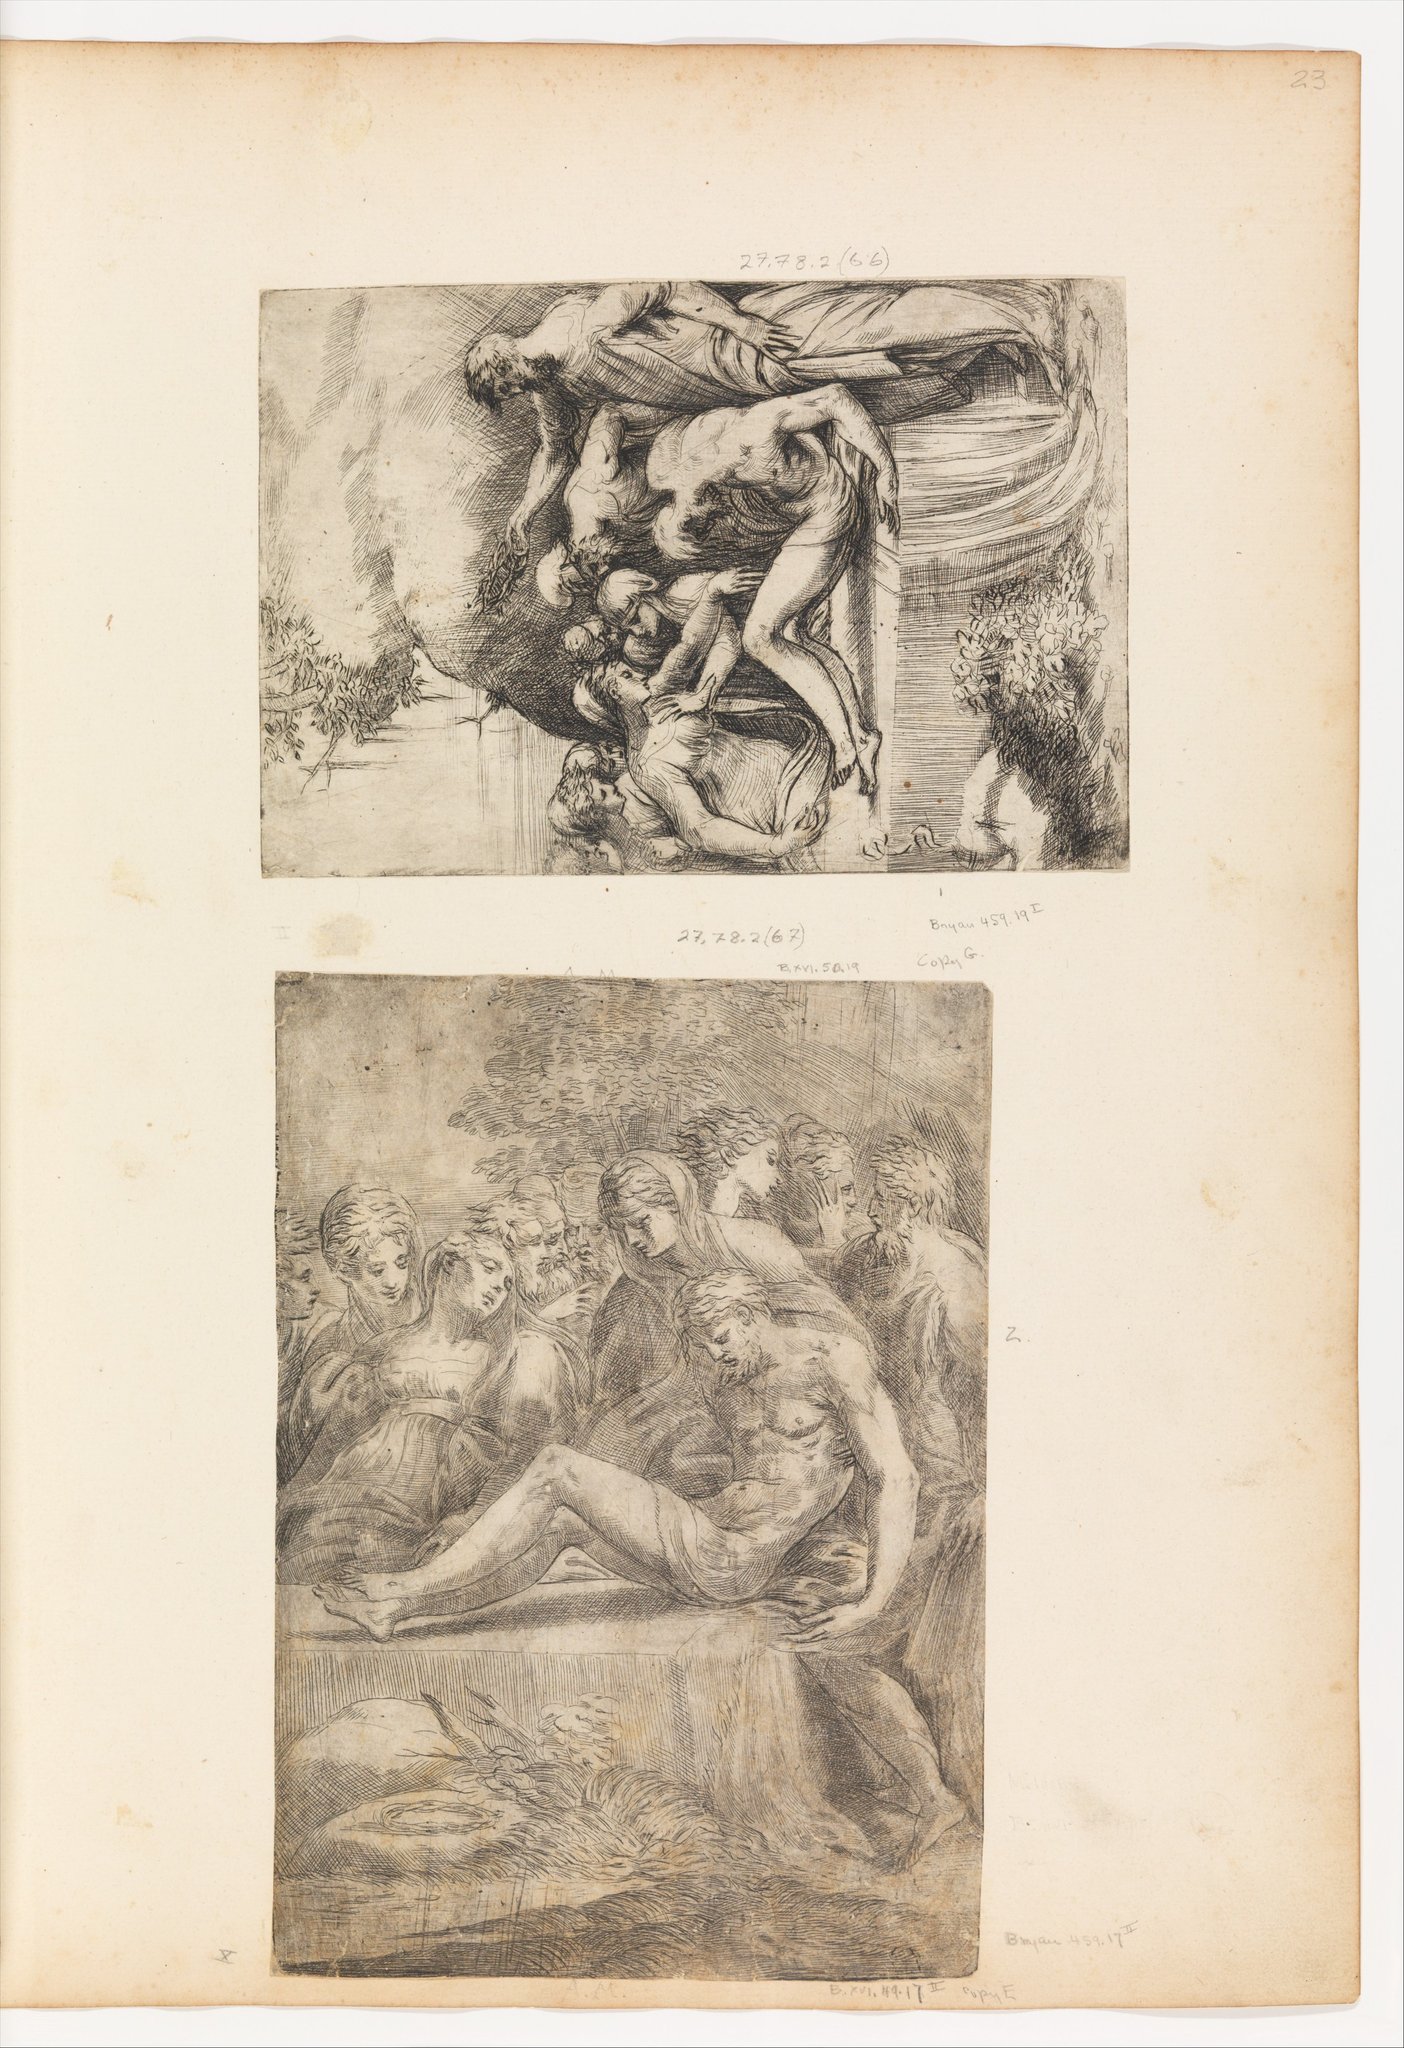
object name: print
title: The Lamentation Over the Dead Christ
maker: andrea schiavone (andrea meldola)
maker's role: artist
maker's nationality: italian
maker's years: 1510-1563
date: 1545-1550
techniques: etching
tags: men,women,christ,lamentation,death